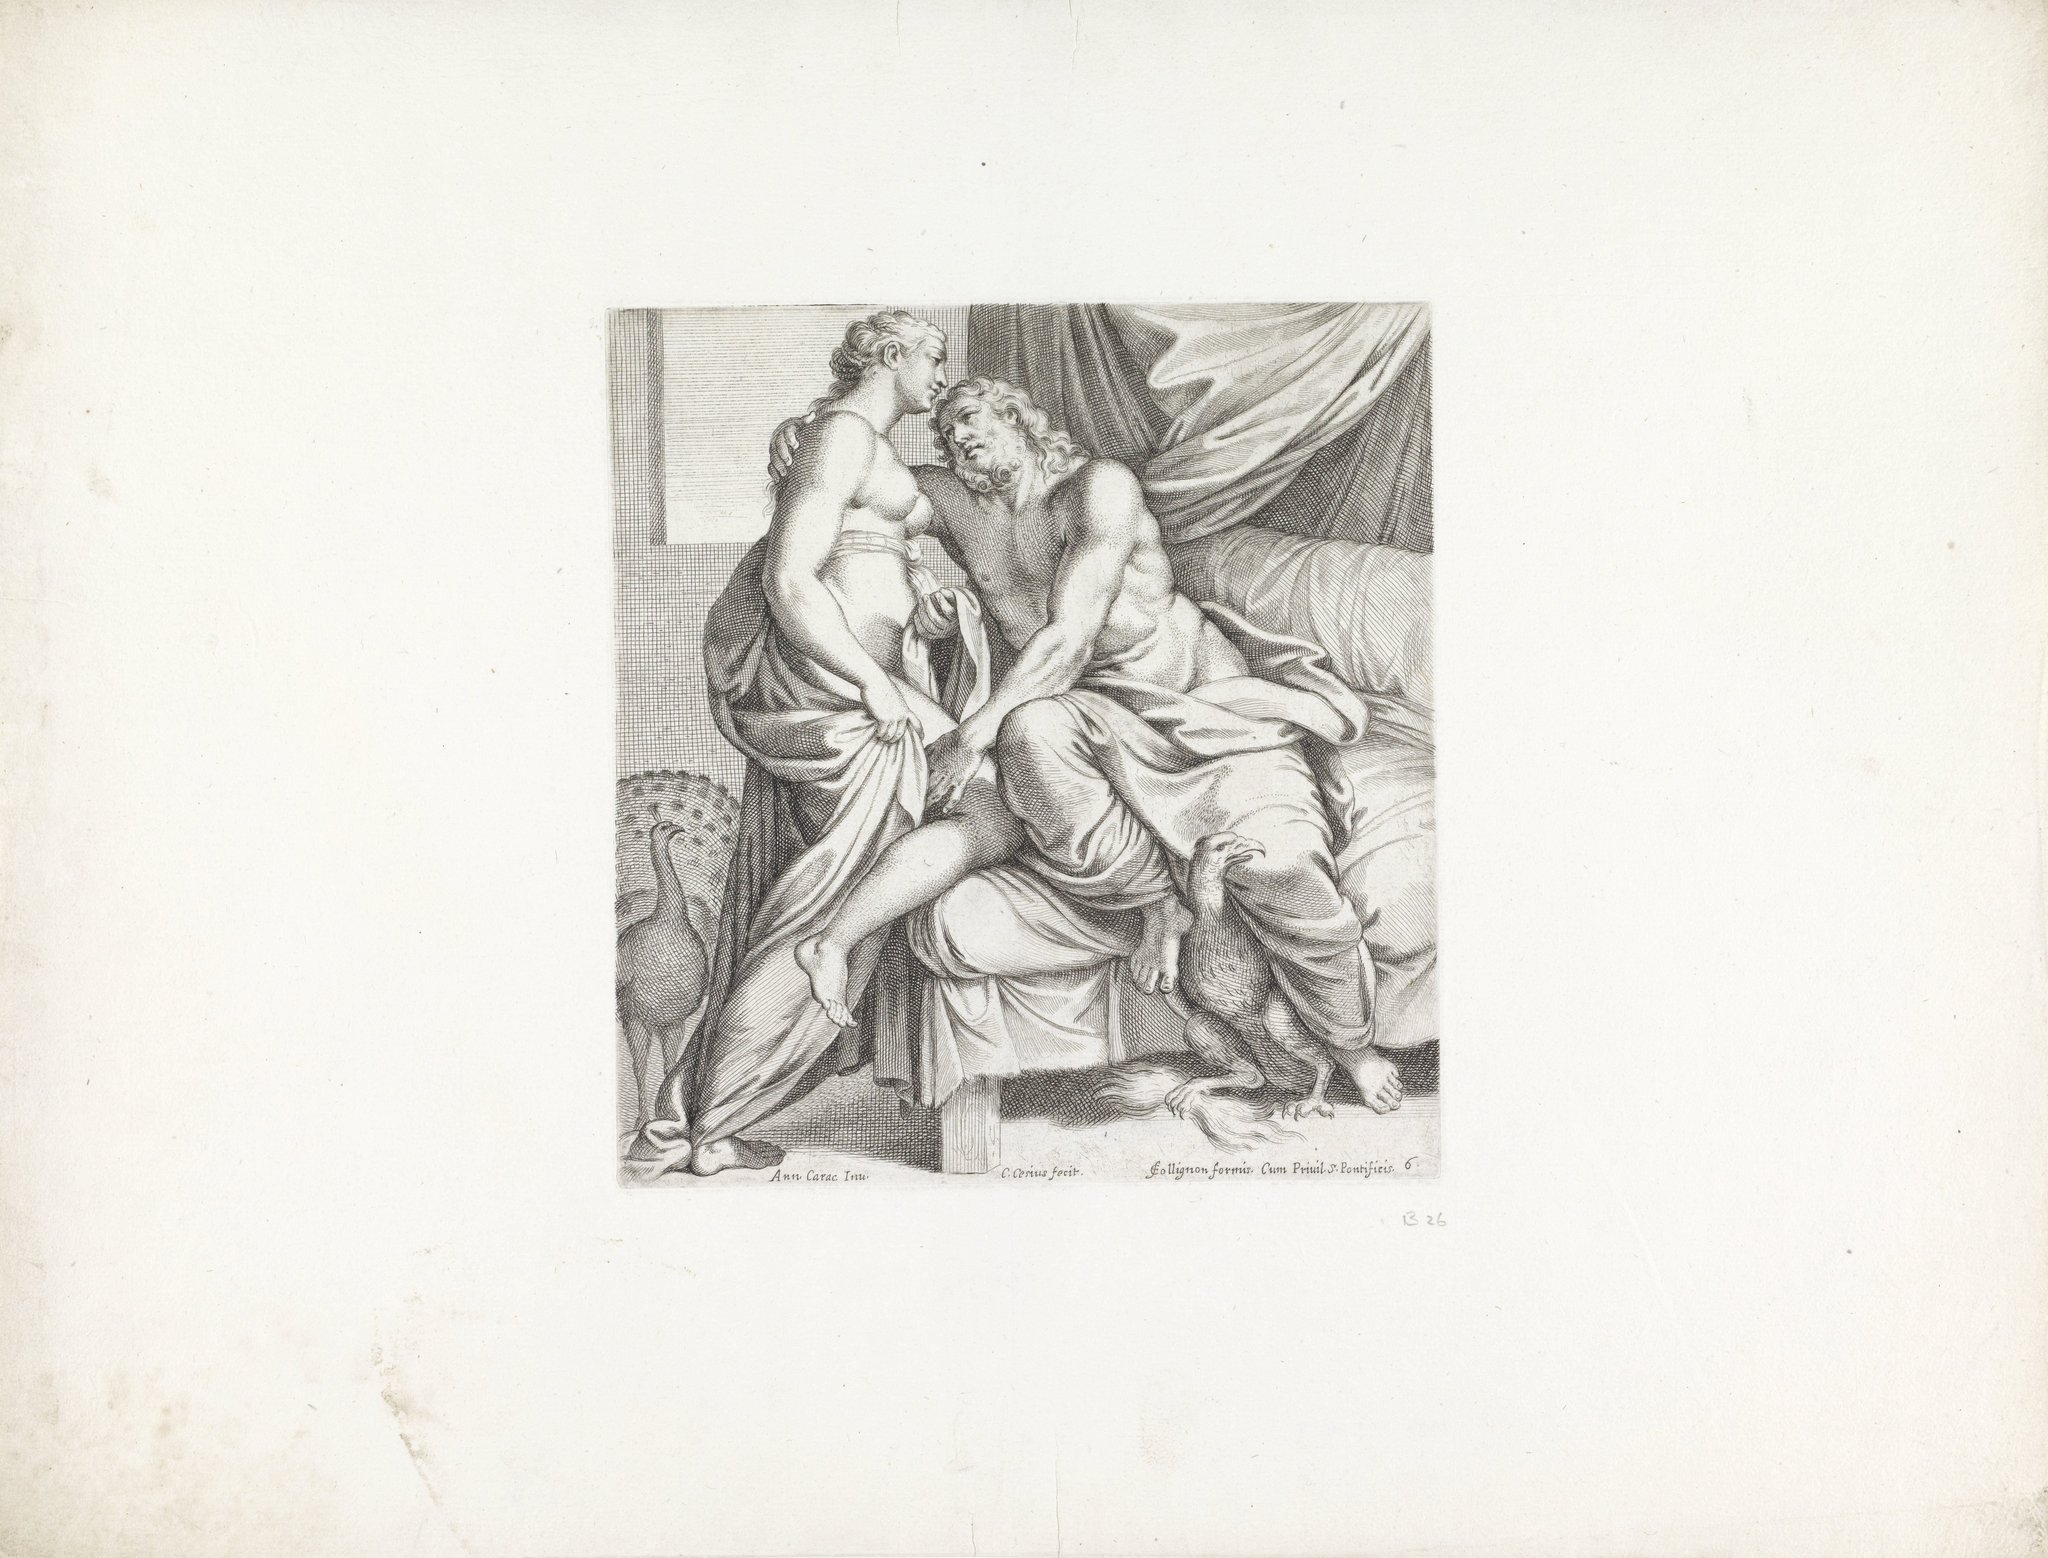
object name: print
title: Schilderingen in Palazzo Farnese te Rome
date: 1656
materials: paper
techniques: etching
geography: vatican city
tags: jupiter and juno as lovers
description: Prent uit een reeks prenten met nummers van 1 tot en met 29 (sommige prenten hebben hetzelfde nummer), plus titelprent en opdracht, naar schilderingen in Palazzo Farnese te Rome.